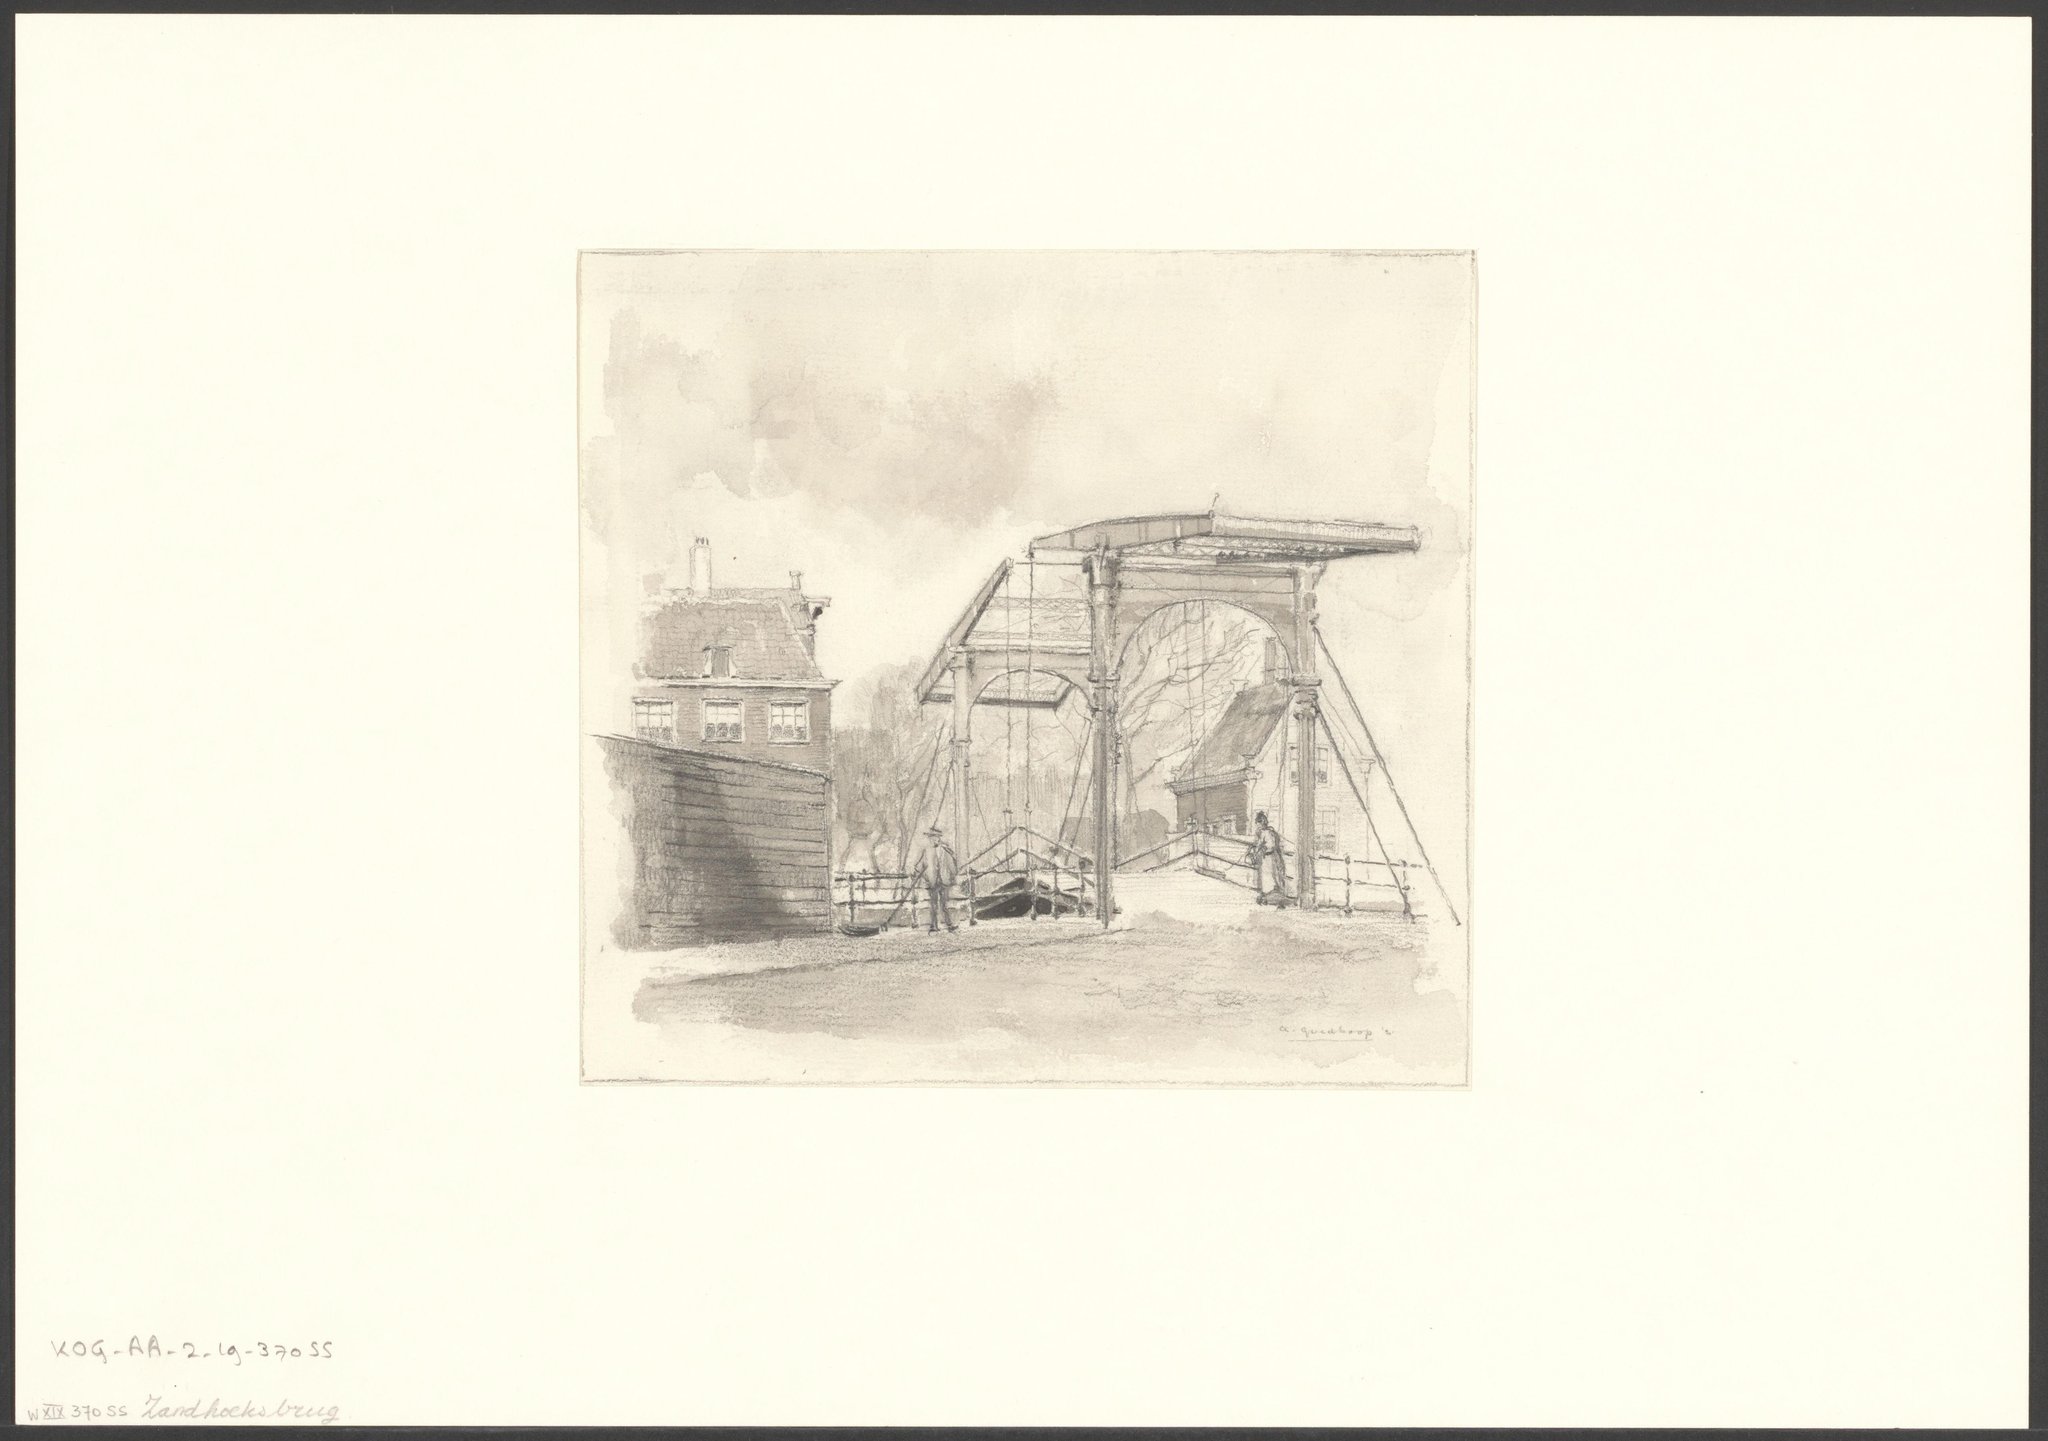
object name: drawing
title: Gezicht op de Zandhoeksbrug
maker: goedkoop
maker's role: draughtsman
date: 1921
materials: ink, paper, pencil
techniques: brush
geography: amsterdam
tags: city-view in general; 'veduta', bridge in city across river, canal, etc.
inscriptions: signature and date: ‘a. goedkoop '21’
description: Tekening binnen de Atlas Van Eck ingedeeld op wijknummer 19.